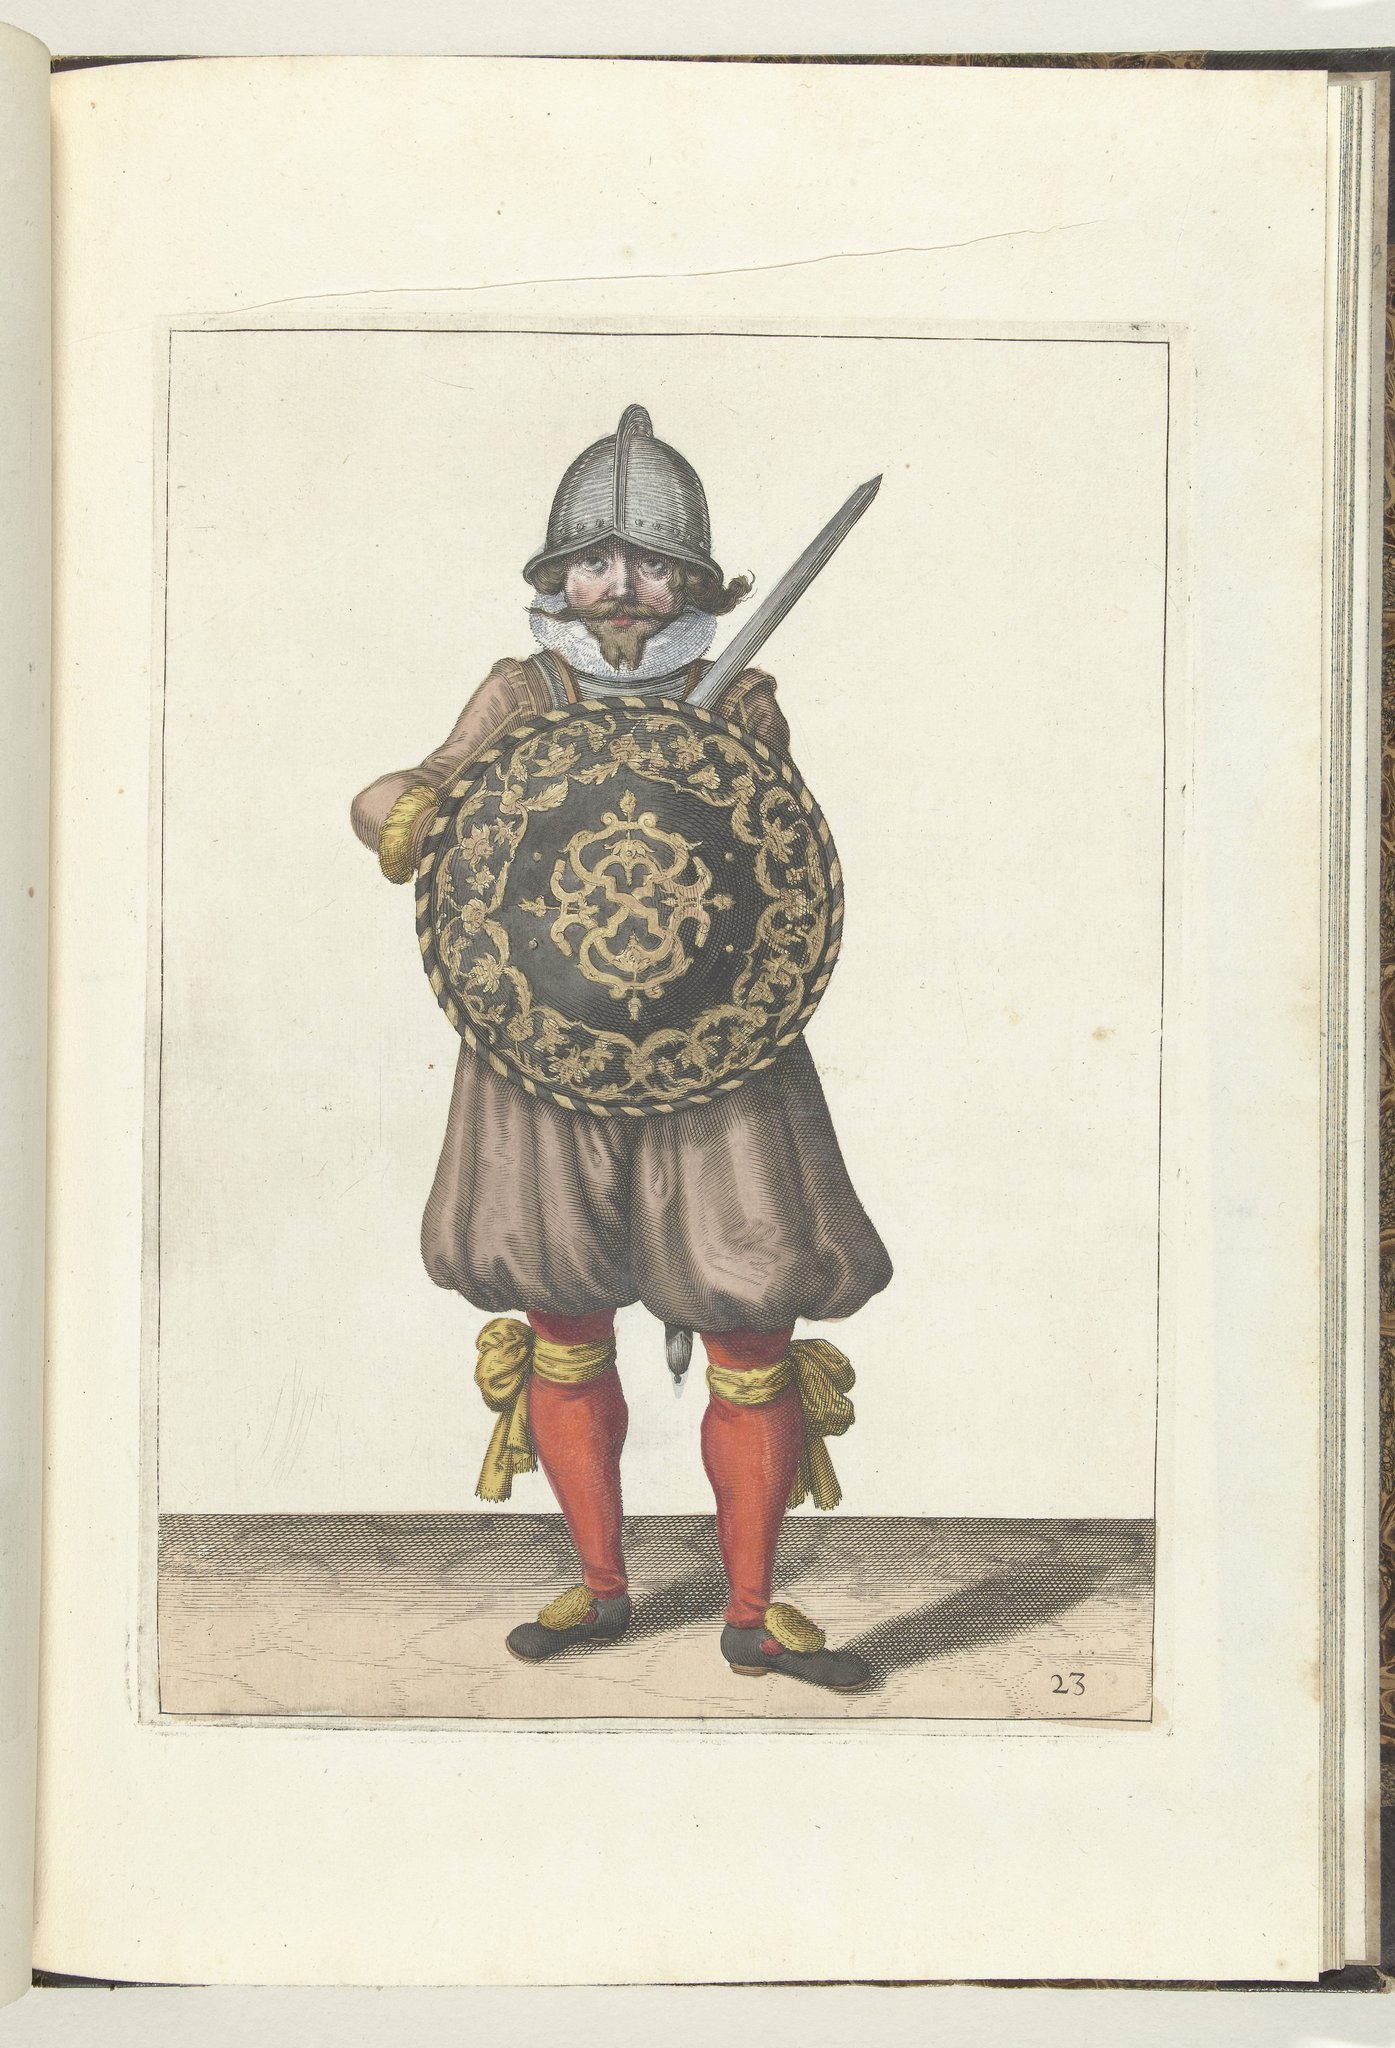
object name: print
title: De exercitie met schild en spies: de soldaat staande in rust zijn rapier rustend op de linkerschouder achter het schild (nr. 23), 1618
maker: Anonymous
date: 1616-1618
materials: paper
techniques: engraving, hand coloring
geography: northern netherlands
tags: the hague, maurice (prince of orange), handling of weapons ~ military training, weapons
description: Illustratie in: Adam van Breen, Nassauische Waffenhandelung [incompleet exemplaar], 1618?, plaat 23. Dit is een Duitse editie van Adam van Breens De Nassausche Wapen-Handelinge, van Schilt, Spies, Rappier ende Targe : beyde figuerlick afgebeelt, ende gestelt na de nieu ordening [van] ... Maurits van Nassau, 's-Gravenhage, [Aert Meuris] 1618. In het exemplaar in de collectie van de Rijksmuseum Research Library (326 F 23).